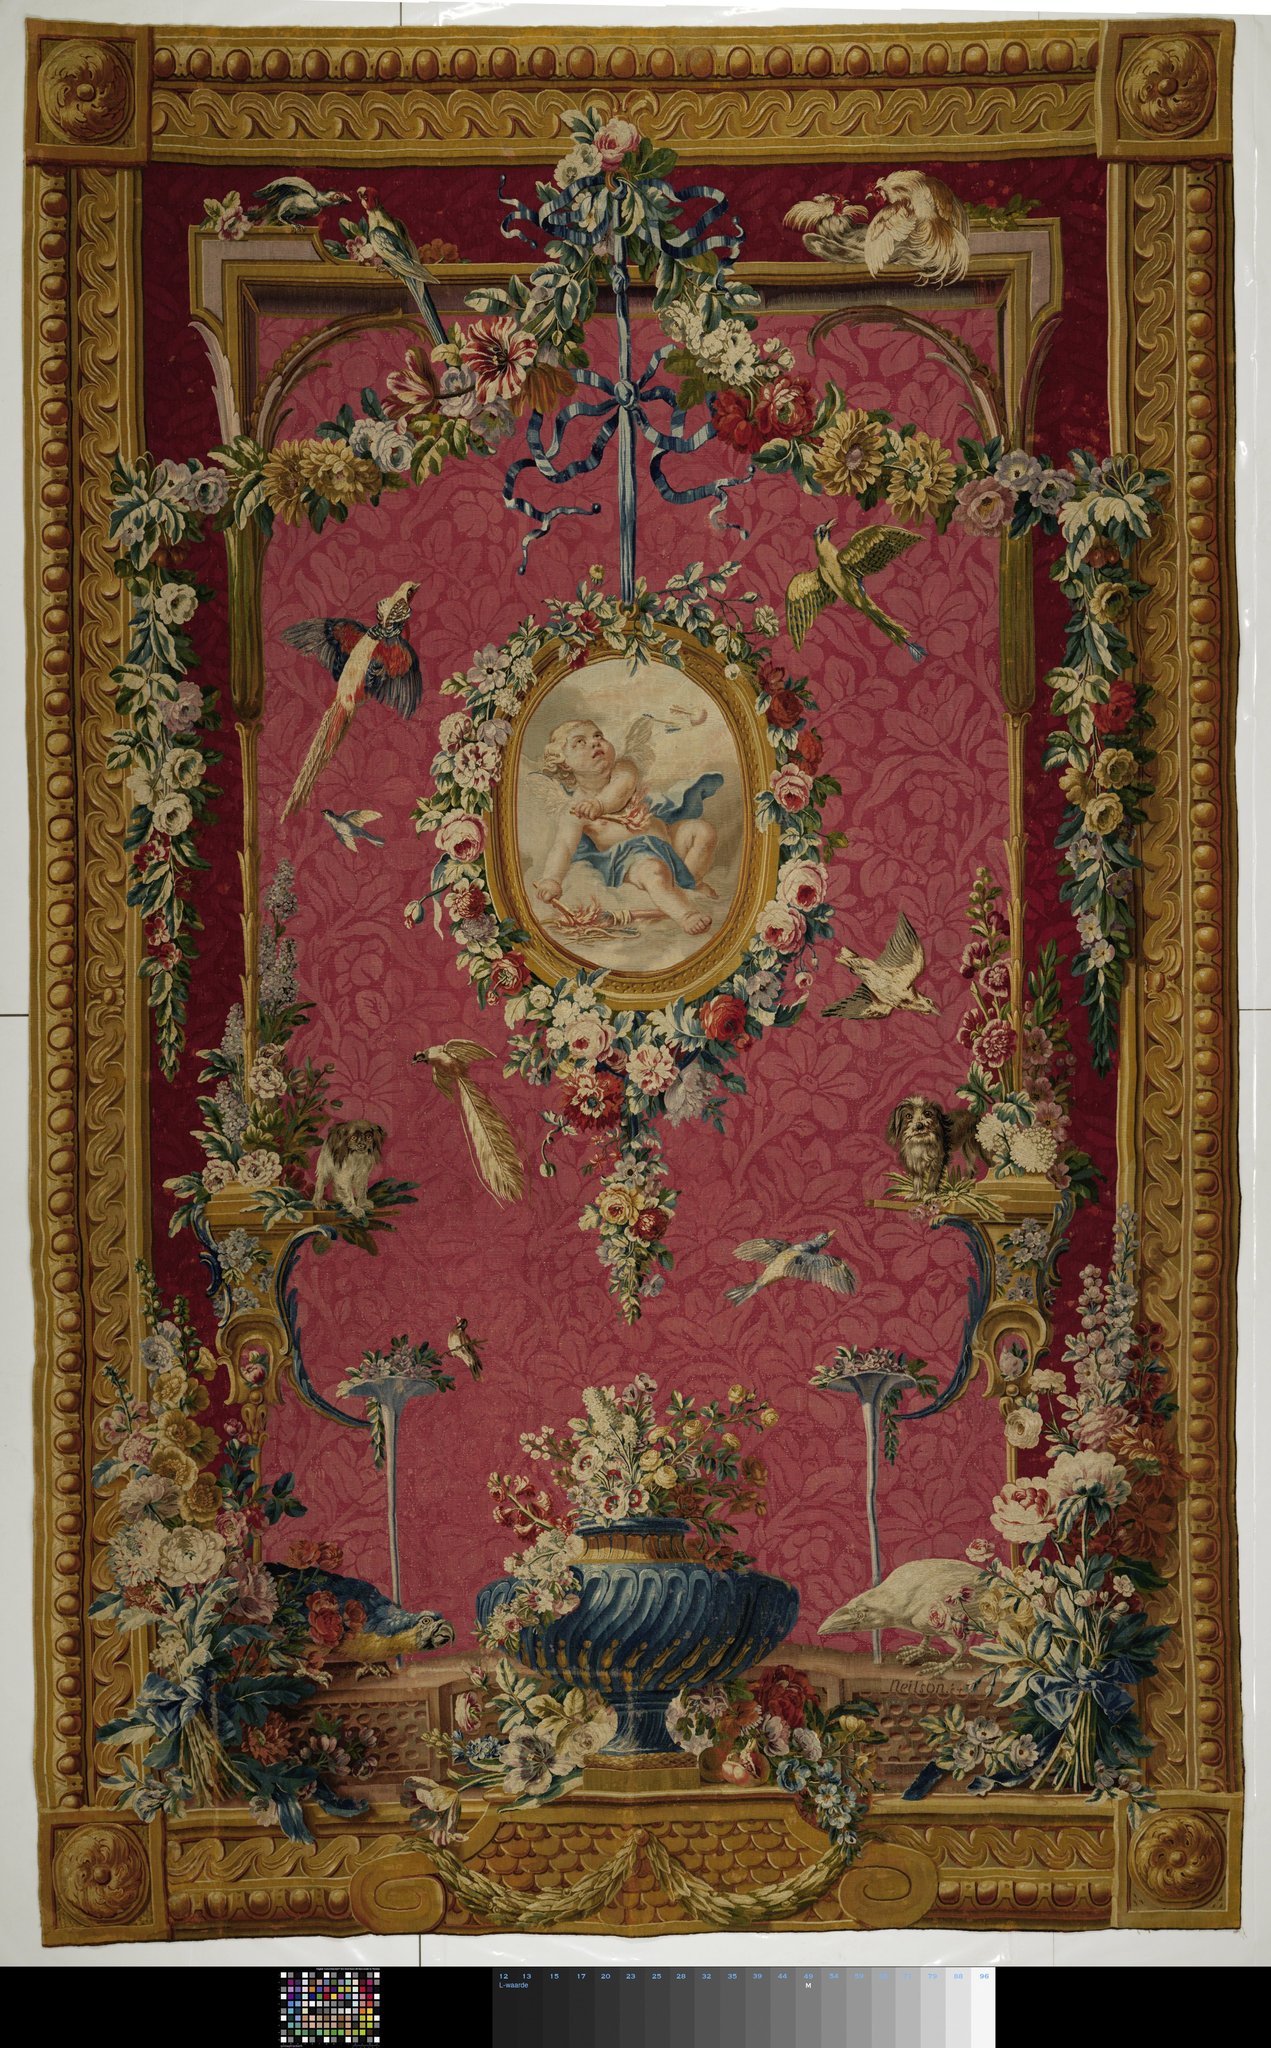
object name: tapestry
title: Cupid in a Medallion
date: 1758-1774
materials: silk, wool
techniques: tapestry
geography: paris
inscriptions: signature: ‘Neilson.éx’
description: To furnish a room, complete tapestry ensembles in this style would be designed. This hanging is part of a series that King Louis XVI presented to Prince Henry of Prussia.